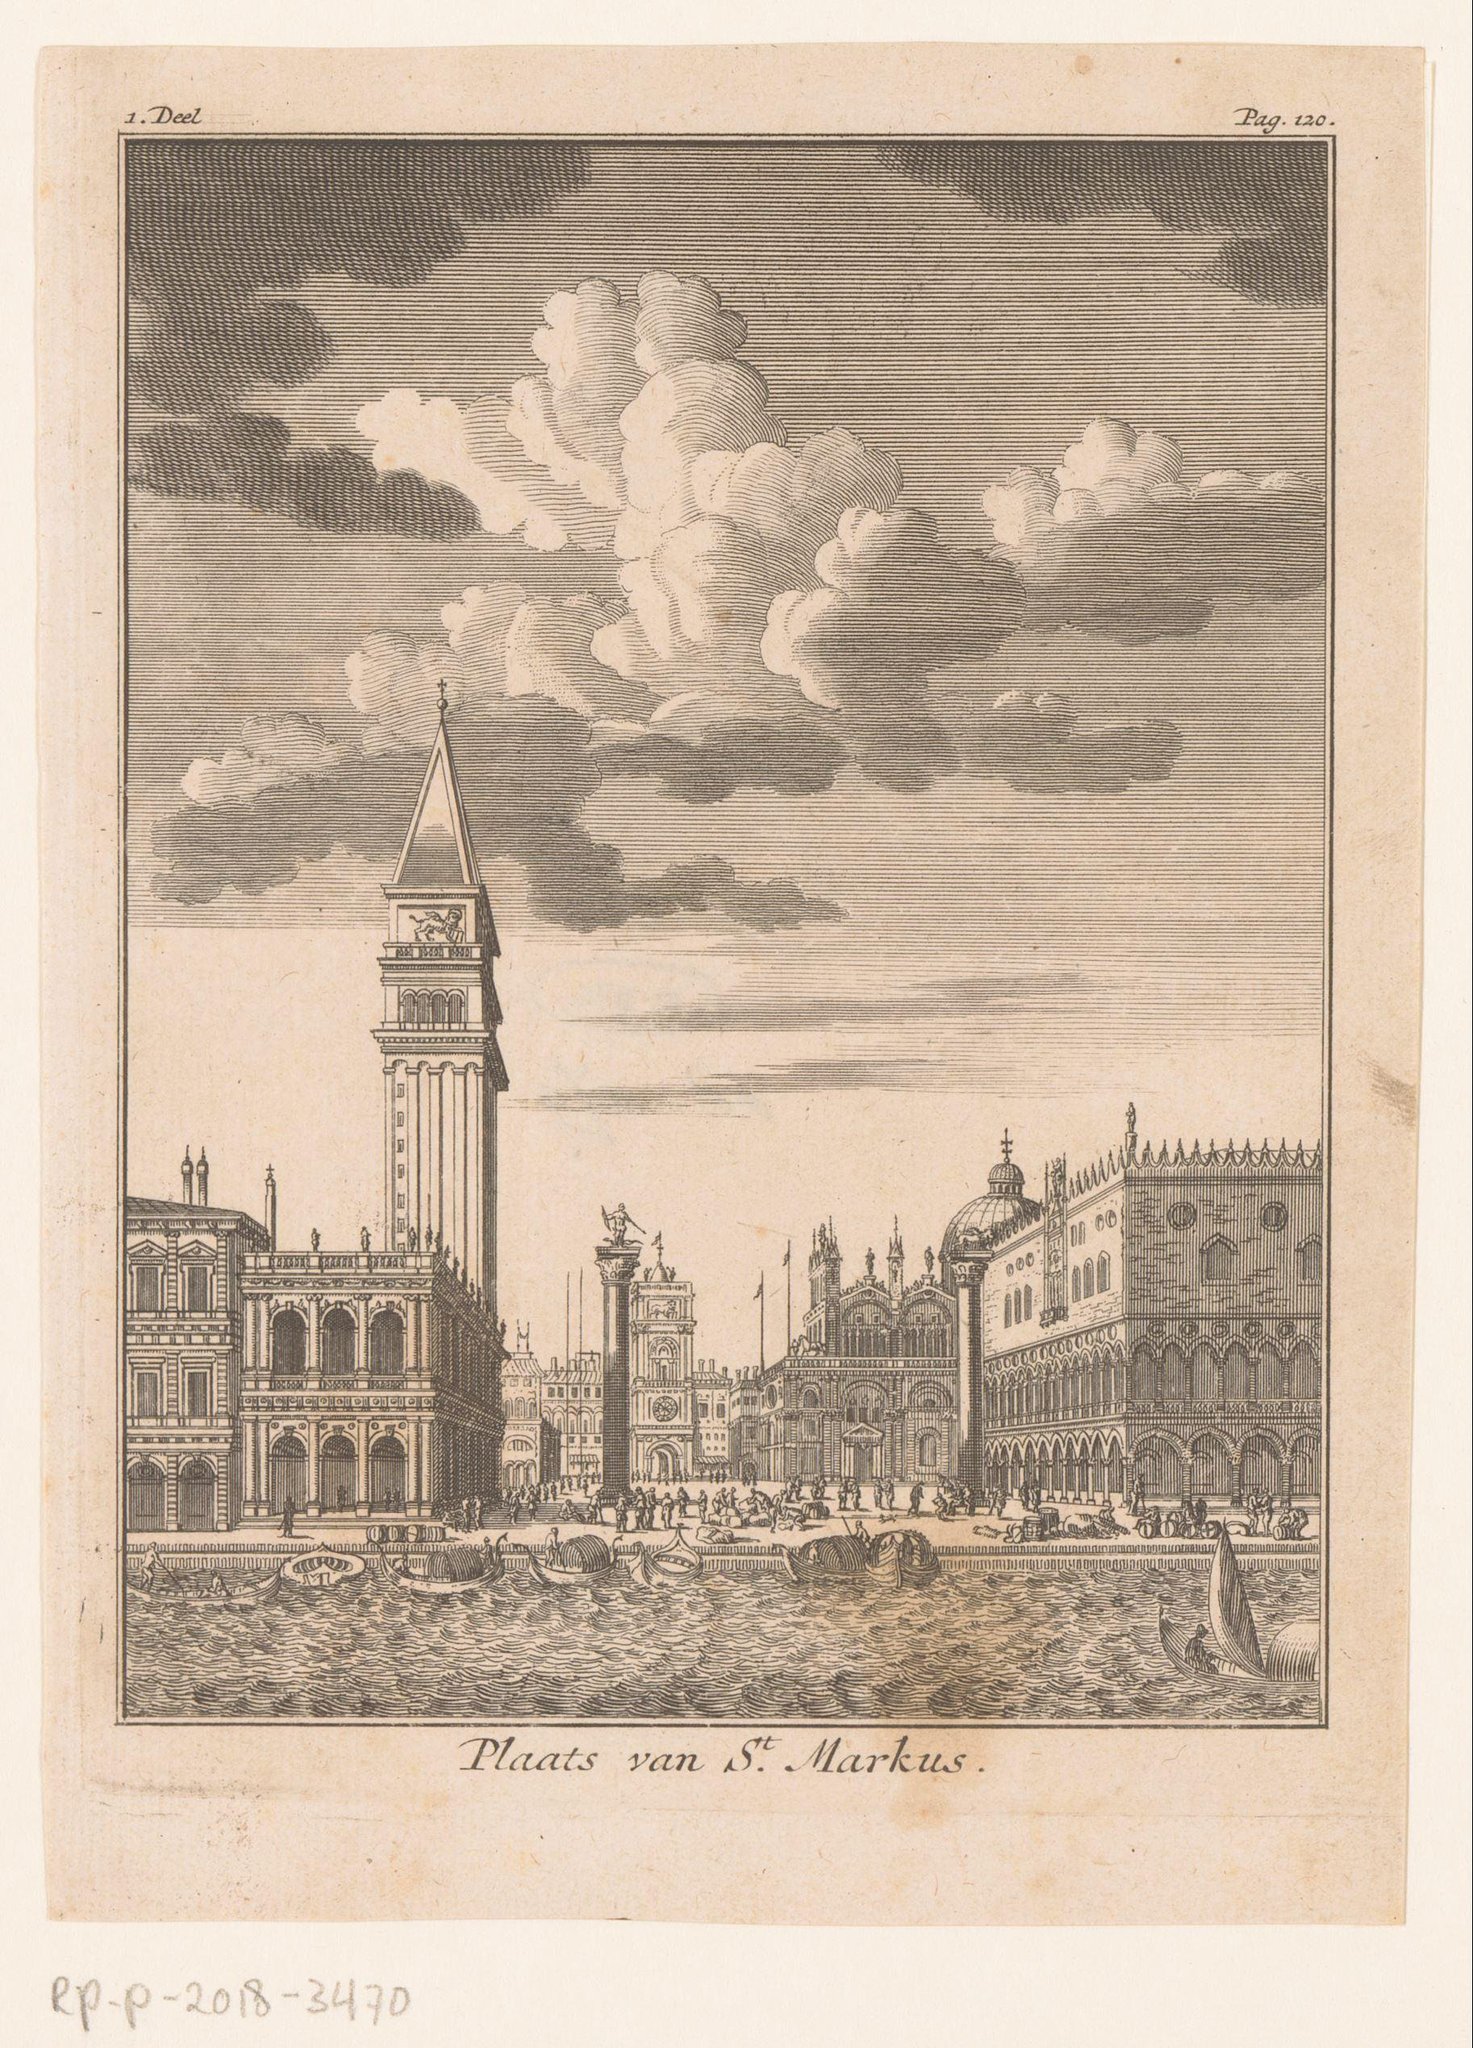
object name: print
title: Gezicht op het San Marcoplein te Venetië vanaf de Canal Grande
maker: Anonymous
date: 1700-1750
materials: paper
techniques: engraving, etching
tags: square, place, circus, etc., city-view, and landscape with man-made constructions, canals, waters (in city)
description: Linksboven: 1. deel. Rechtsboven: pag. 120.